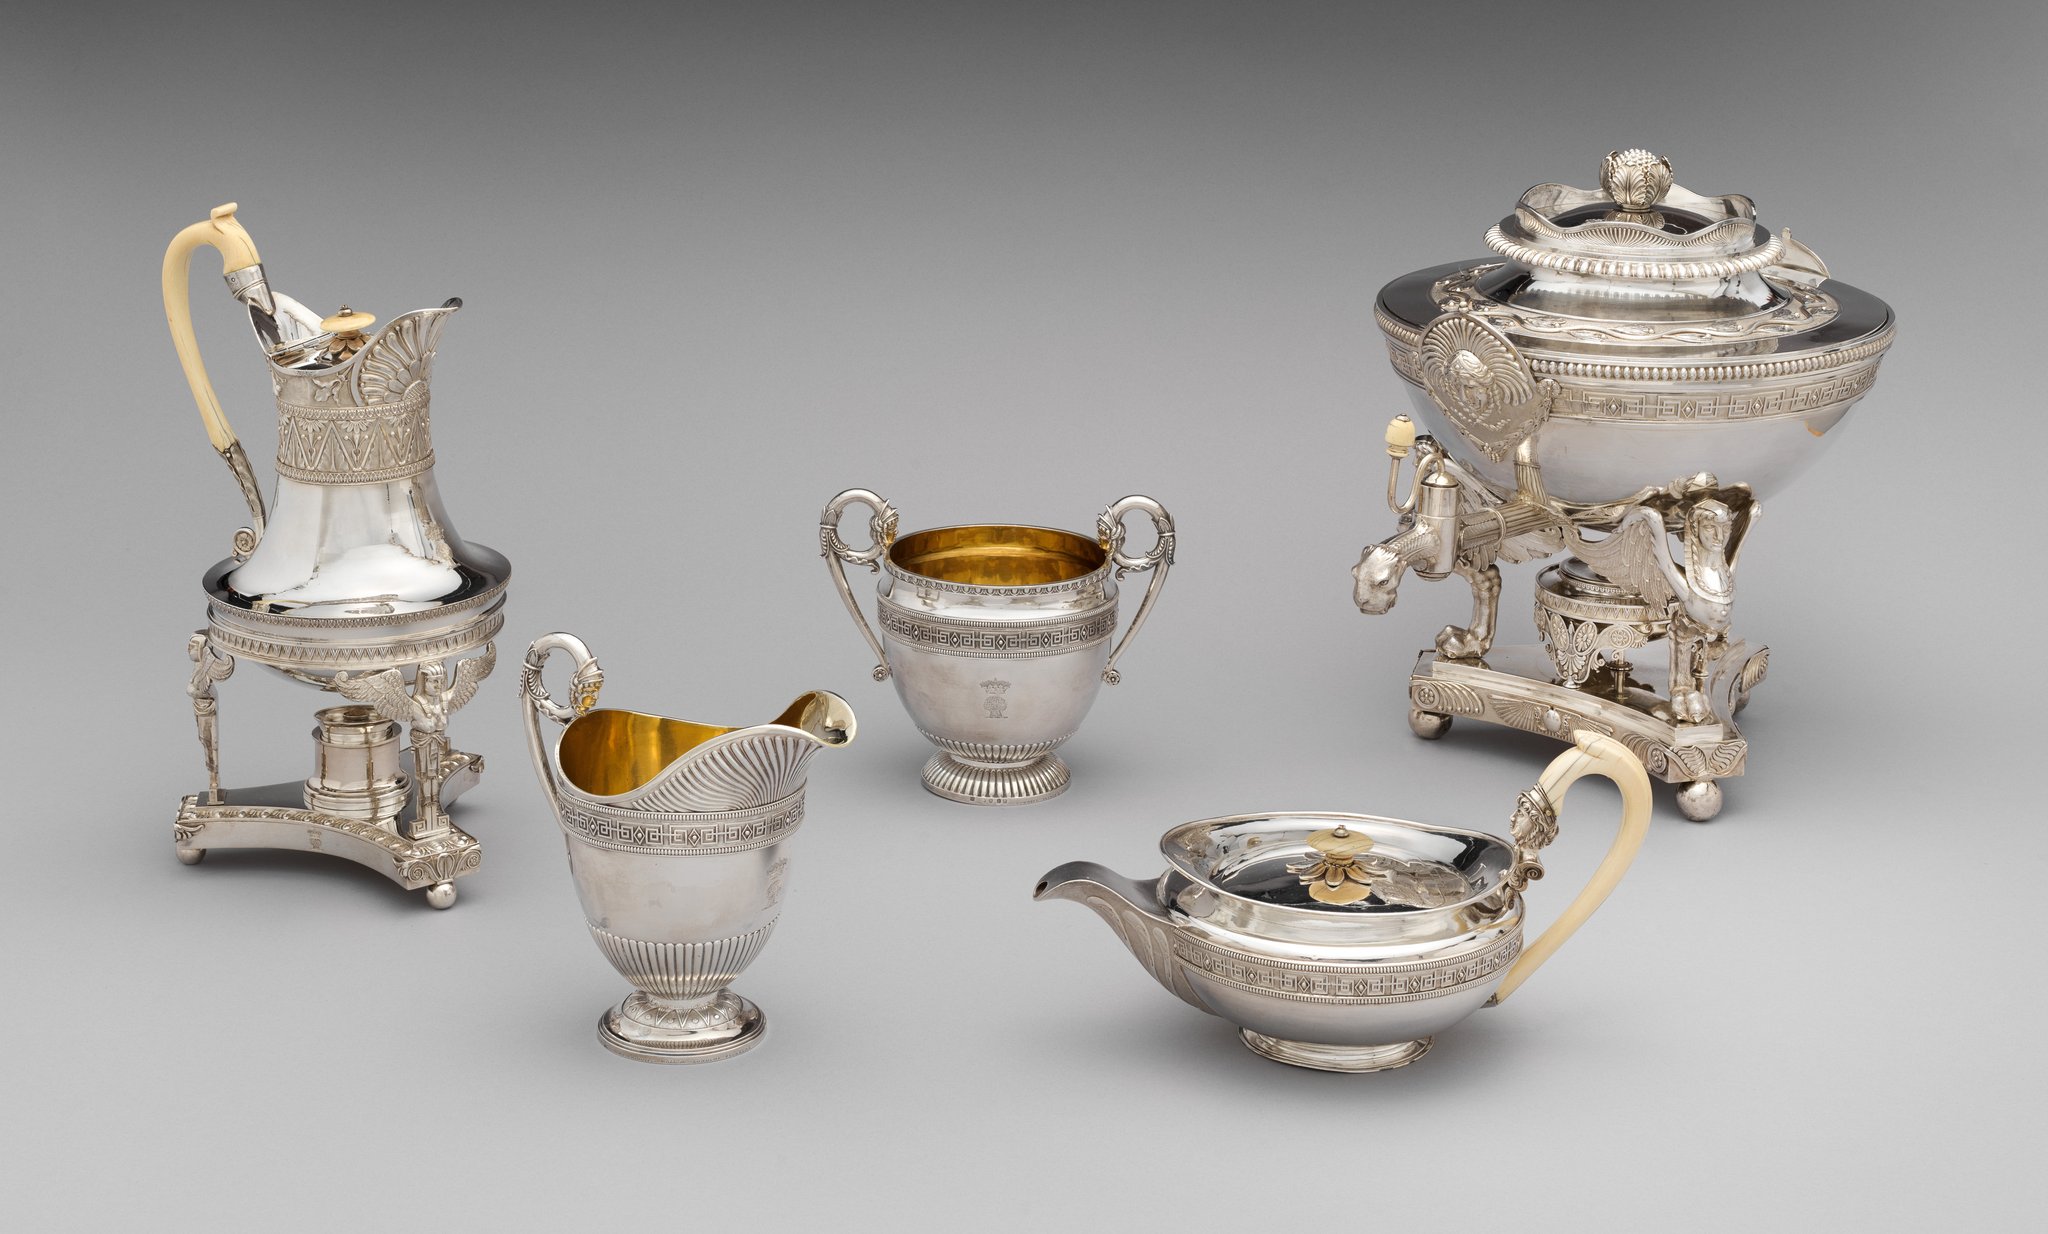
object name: service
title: The Duke of Buckingham Tea and Coffee Service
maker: digby scott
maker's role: maker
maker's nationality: british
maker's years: 1780-1880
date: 1804-1805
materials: ivory, silver